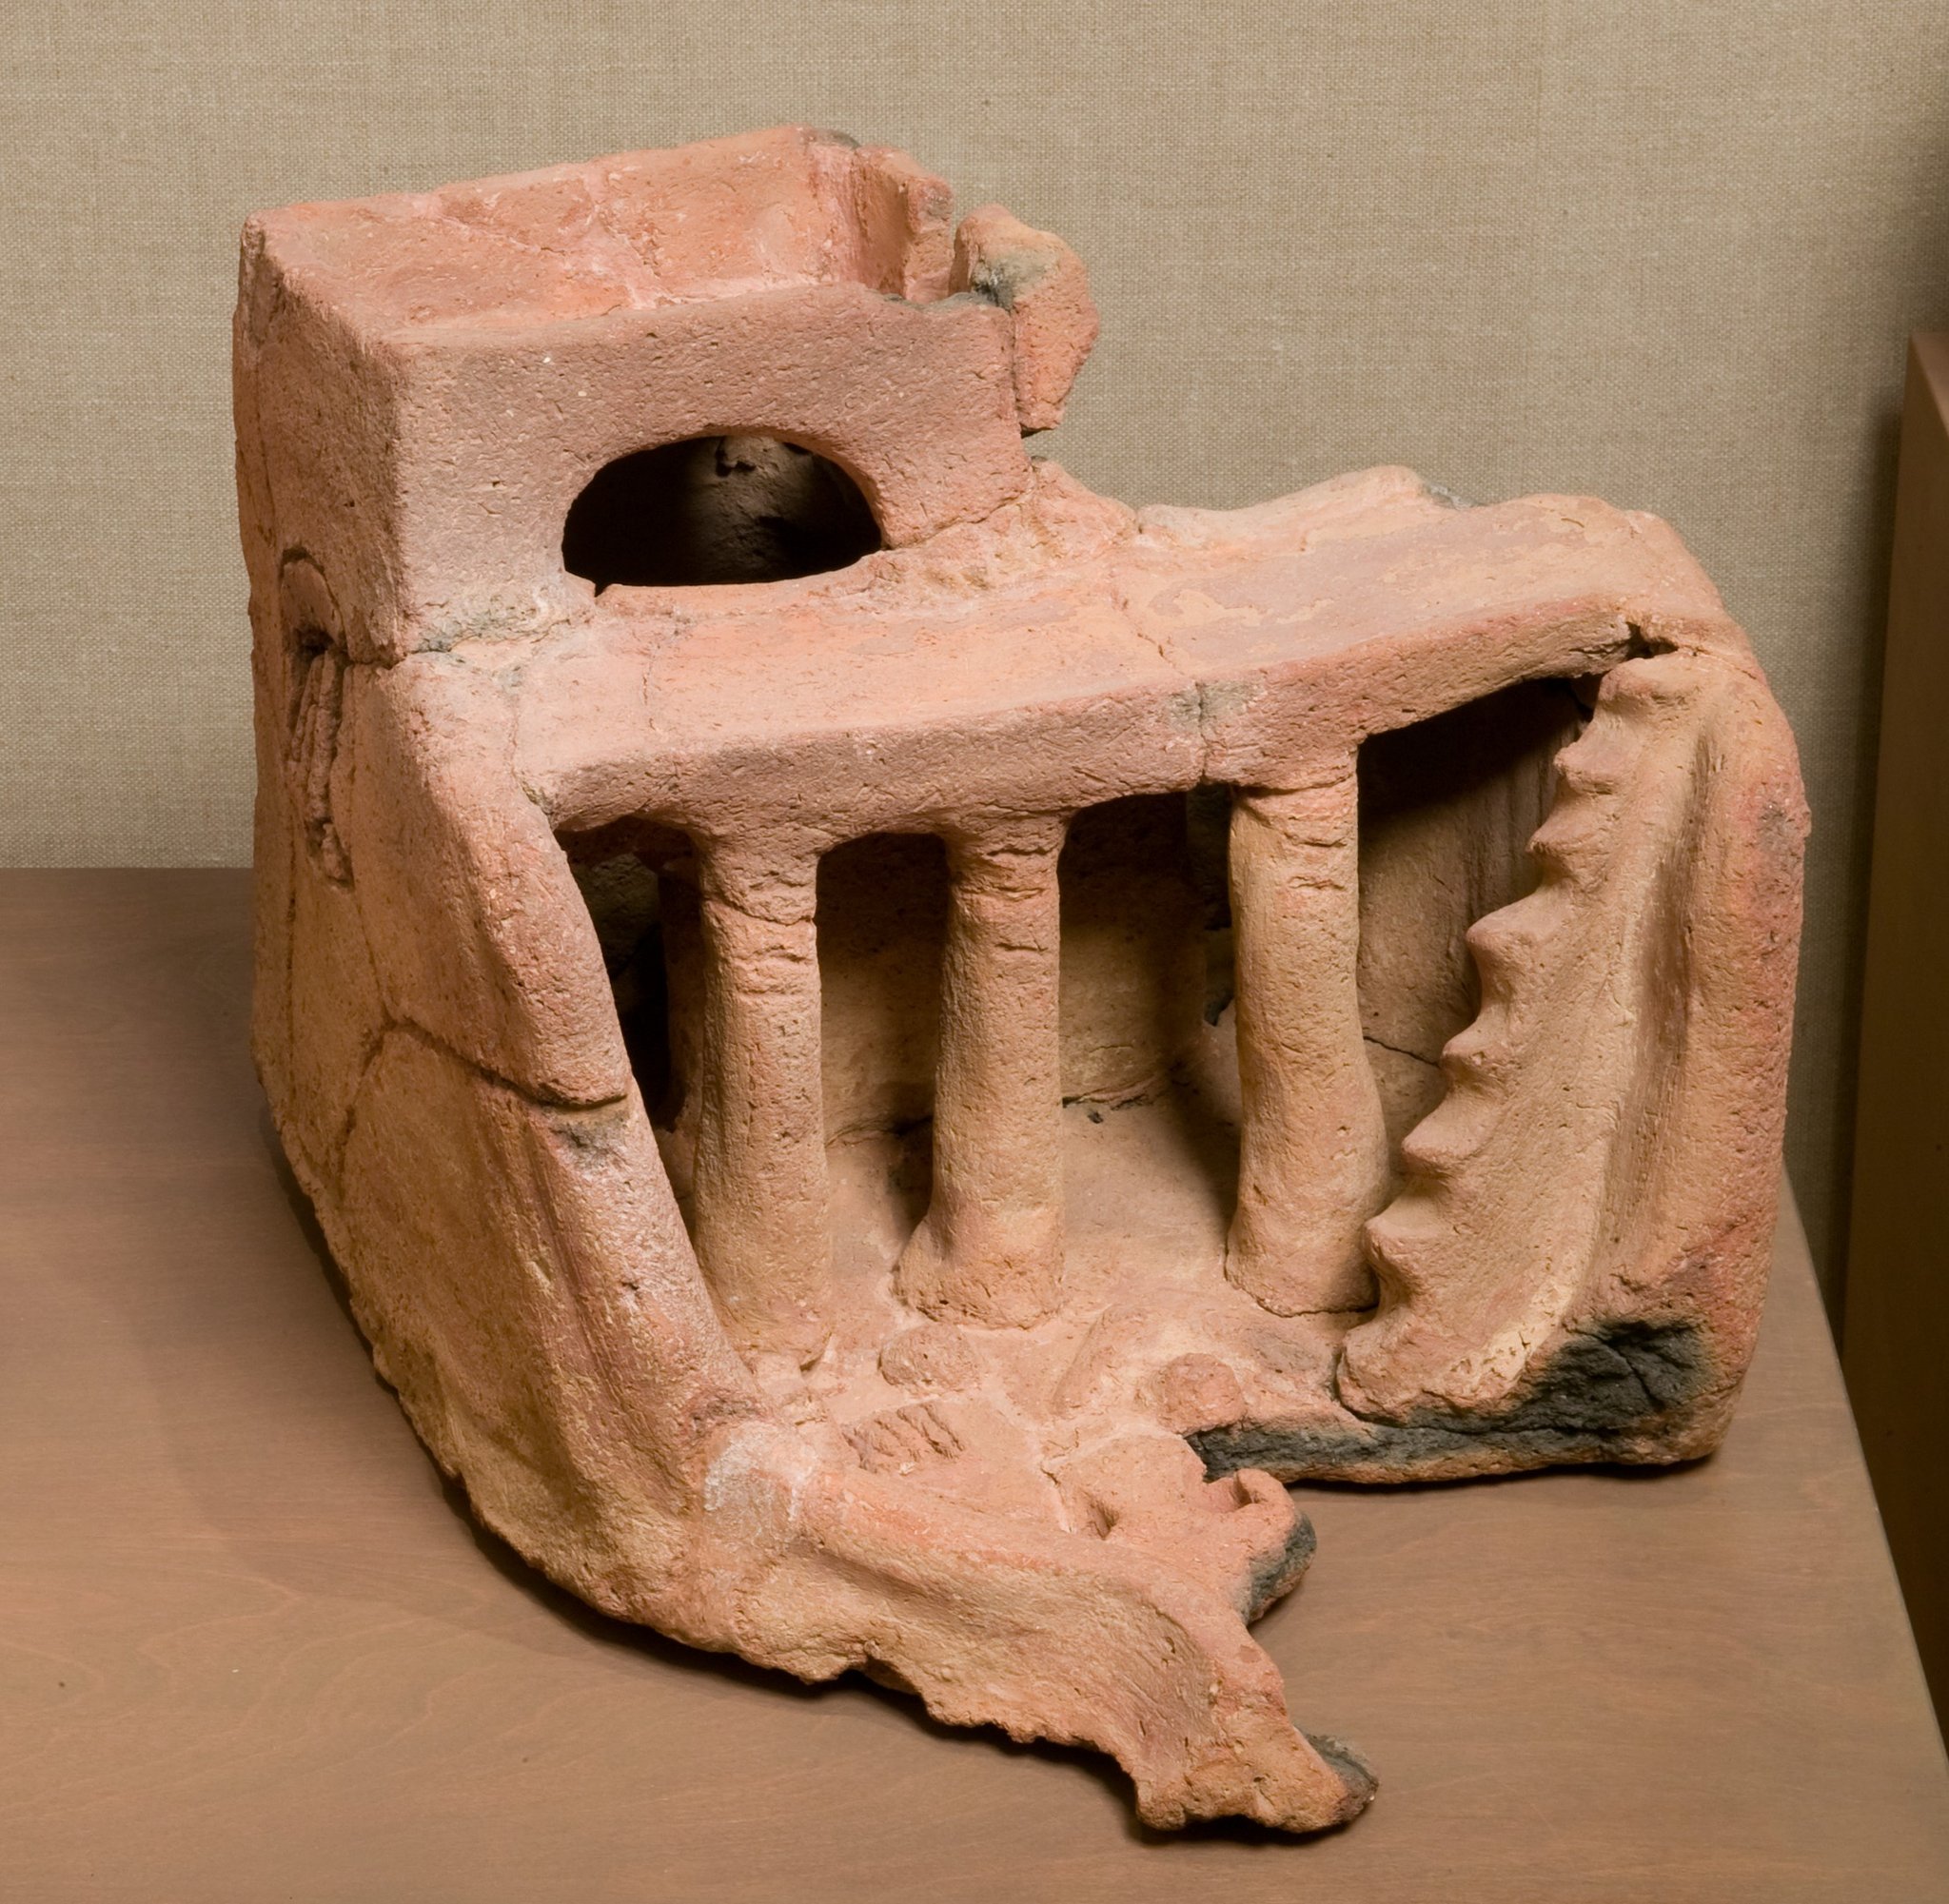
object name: model, house, soul house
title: Model of a House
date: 1750-1700 BCE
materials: pottery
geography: egypt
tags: houses